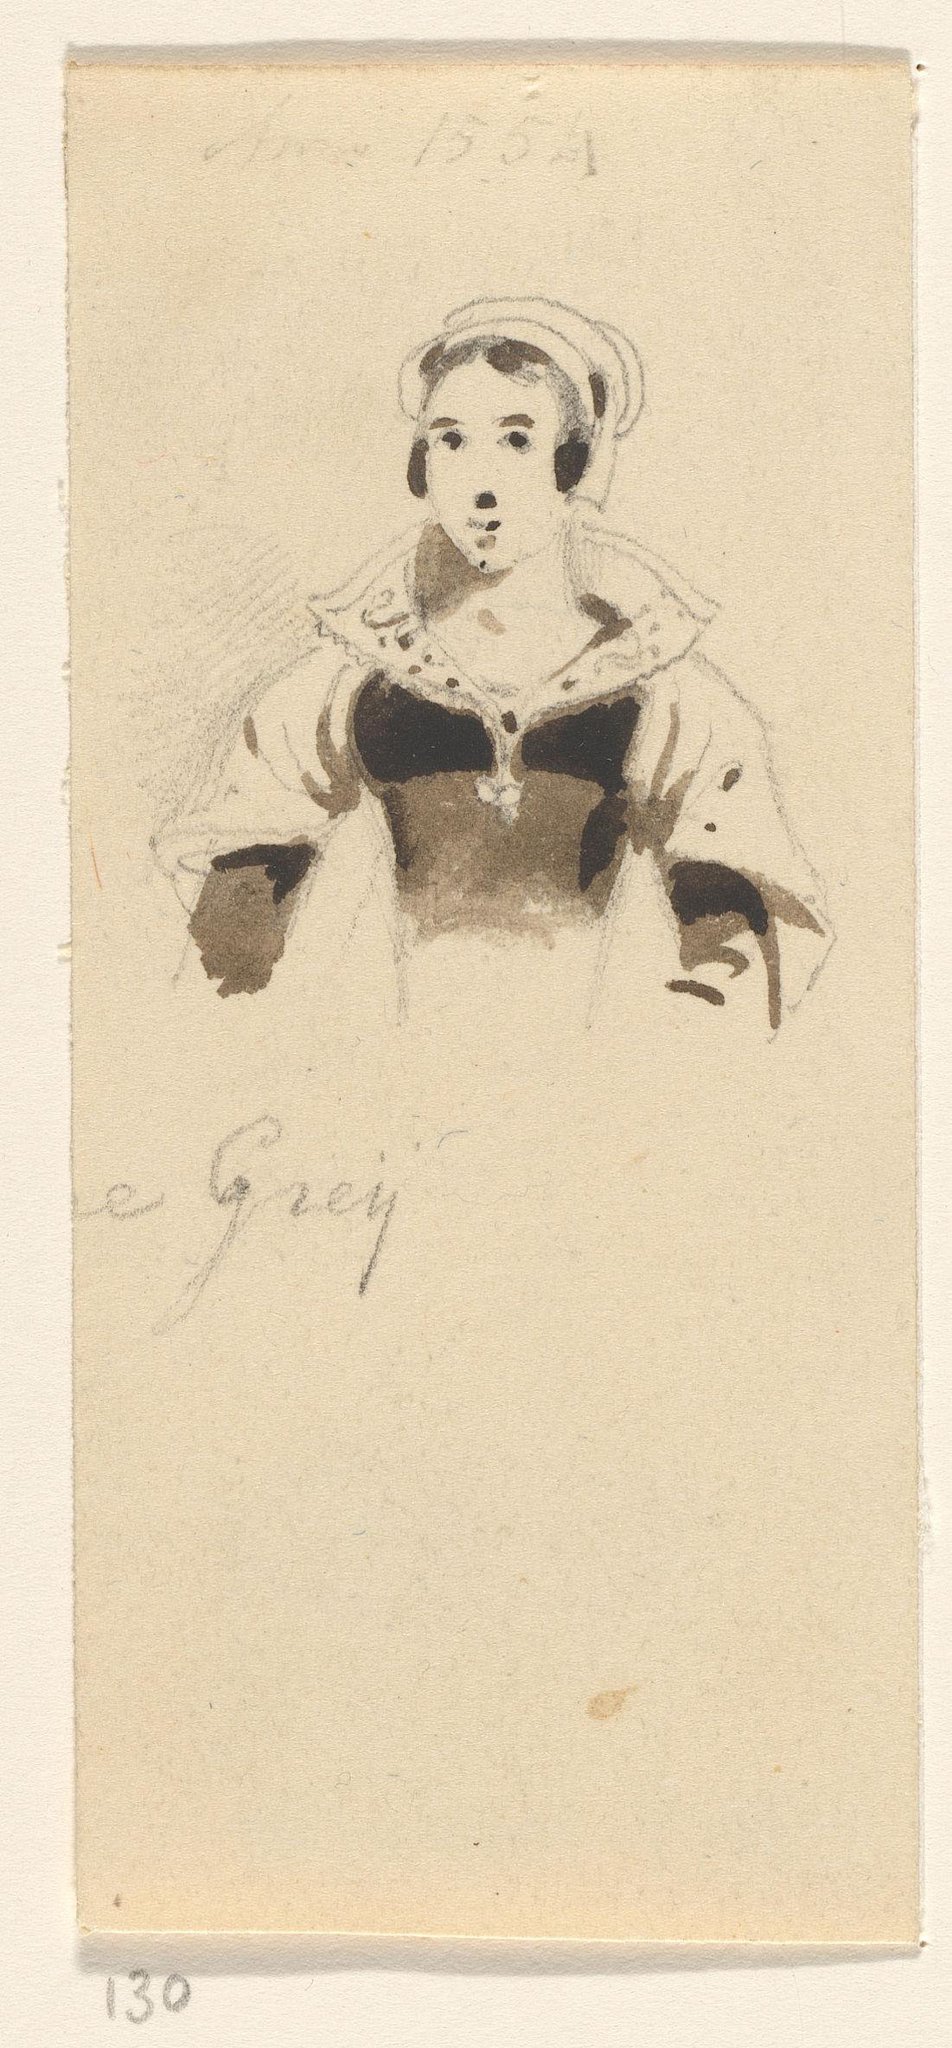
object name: drawing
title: Portret van Jane Grey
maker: johannes bosboom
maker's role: draughtsman, painter, print maker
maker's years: 1817-1891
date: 1827-1891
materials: paper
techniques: brush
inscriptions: date: ‘Anno 1554’, annotation: ‘e Greij [afgesneden]’